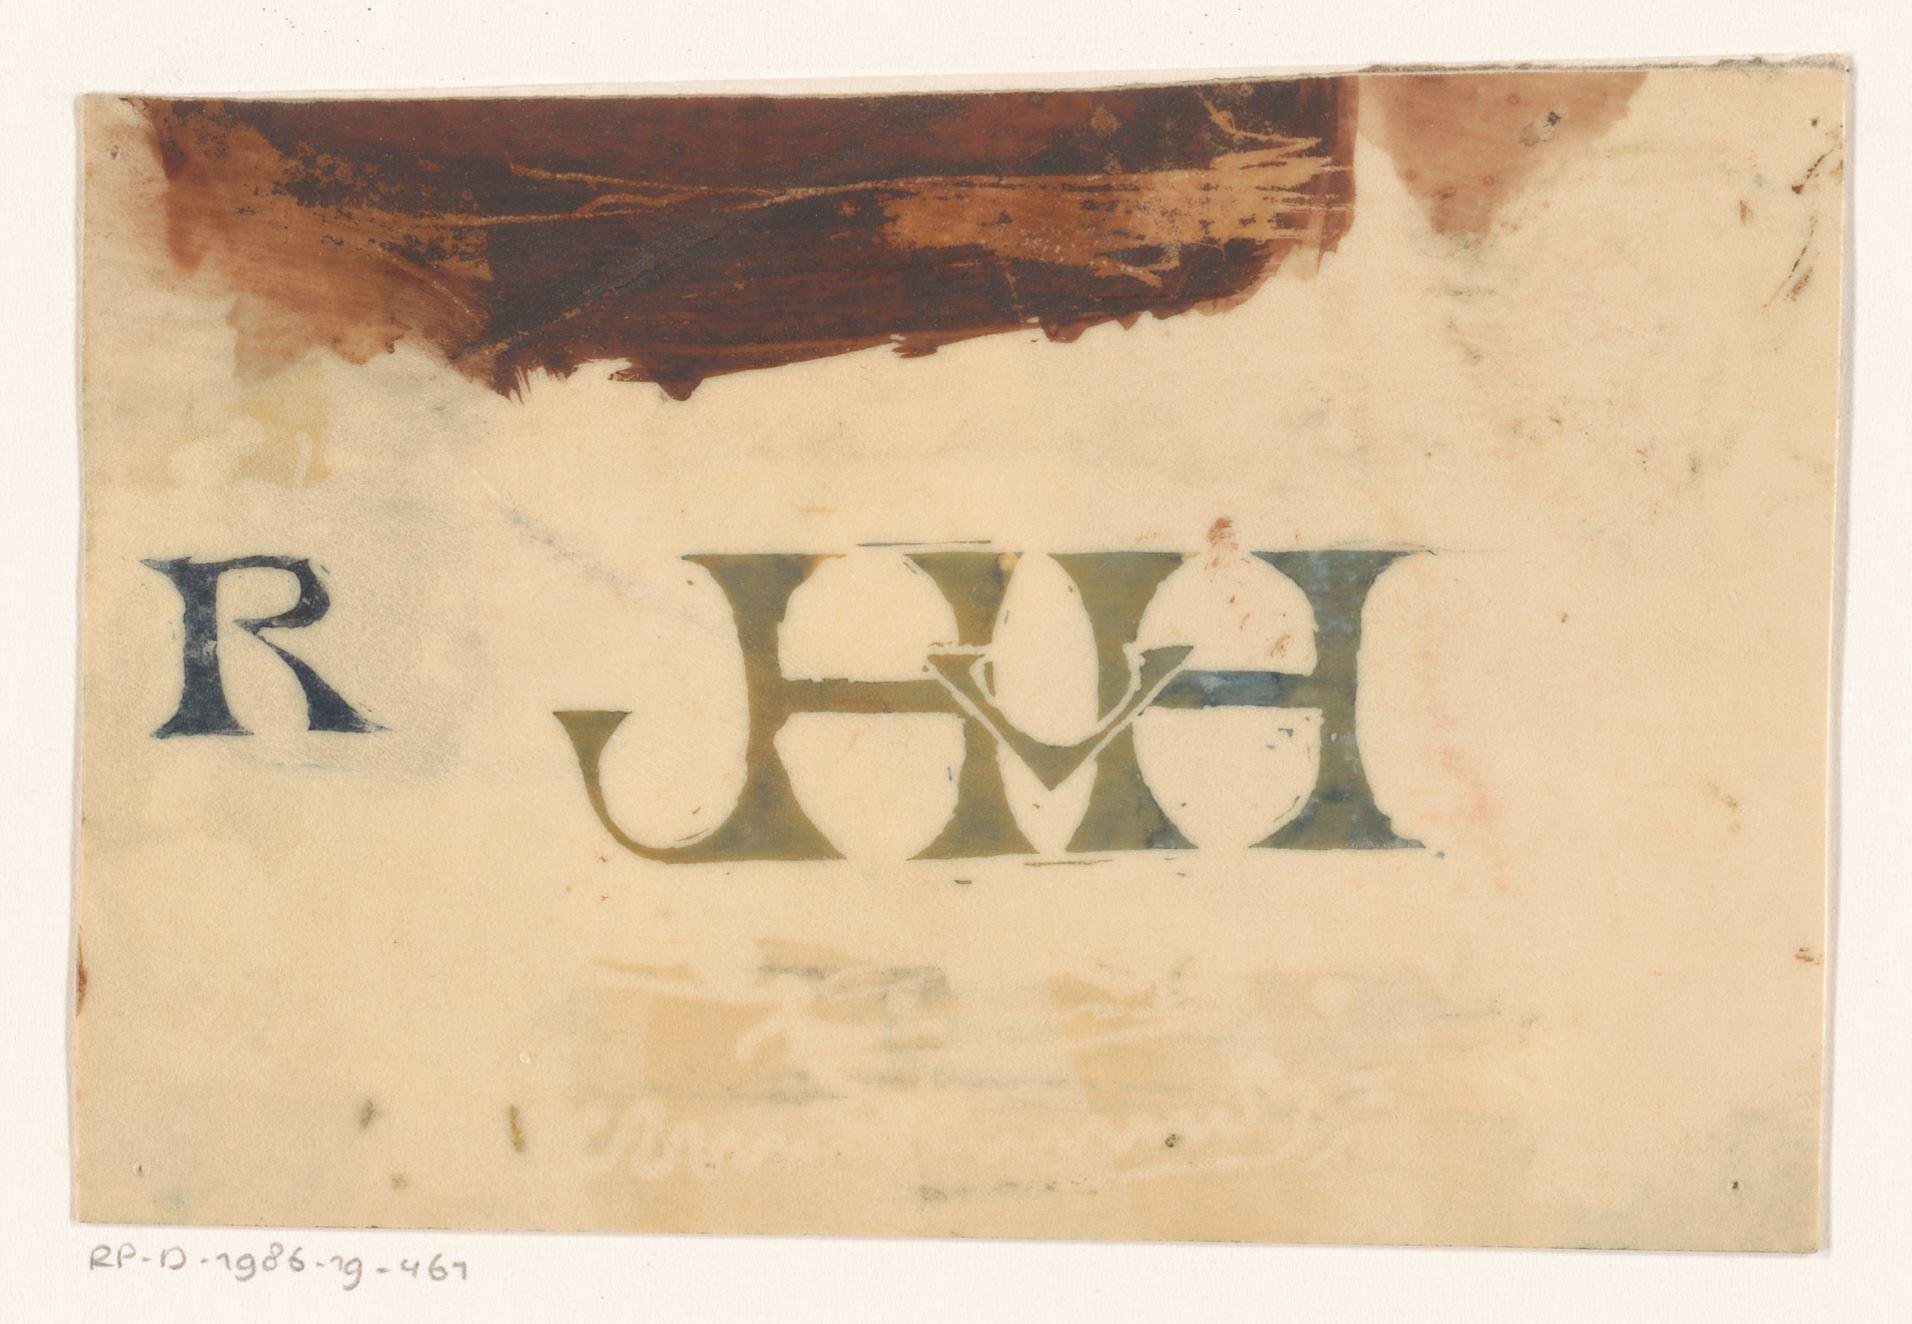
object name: print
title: Monogram JHvH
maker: reinier willem petrus de vries (1874-1953)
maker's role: draughtsman, print maker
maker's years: 1874-1953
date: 1884-1952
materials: parchment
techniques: printing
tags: magic mathematical figures; magic numbers, words, monograms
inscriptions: collector's mark: ‘R:MVS.’